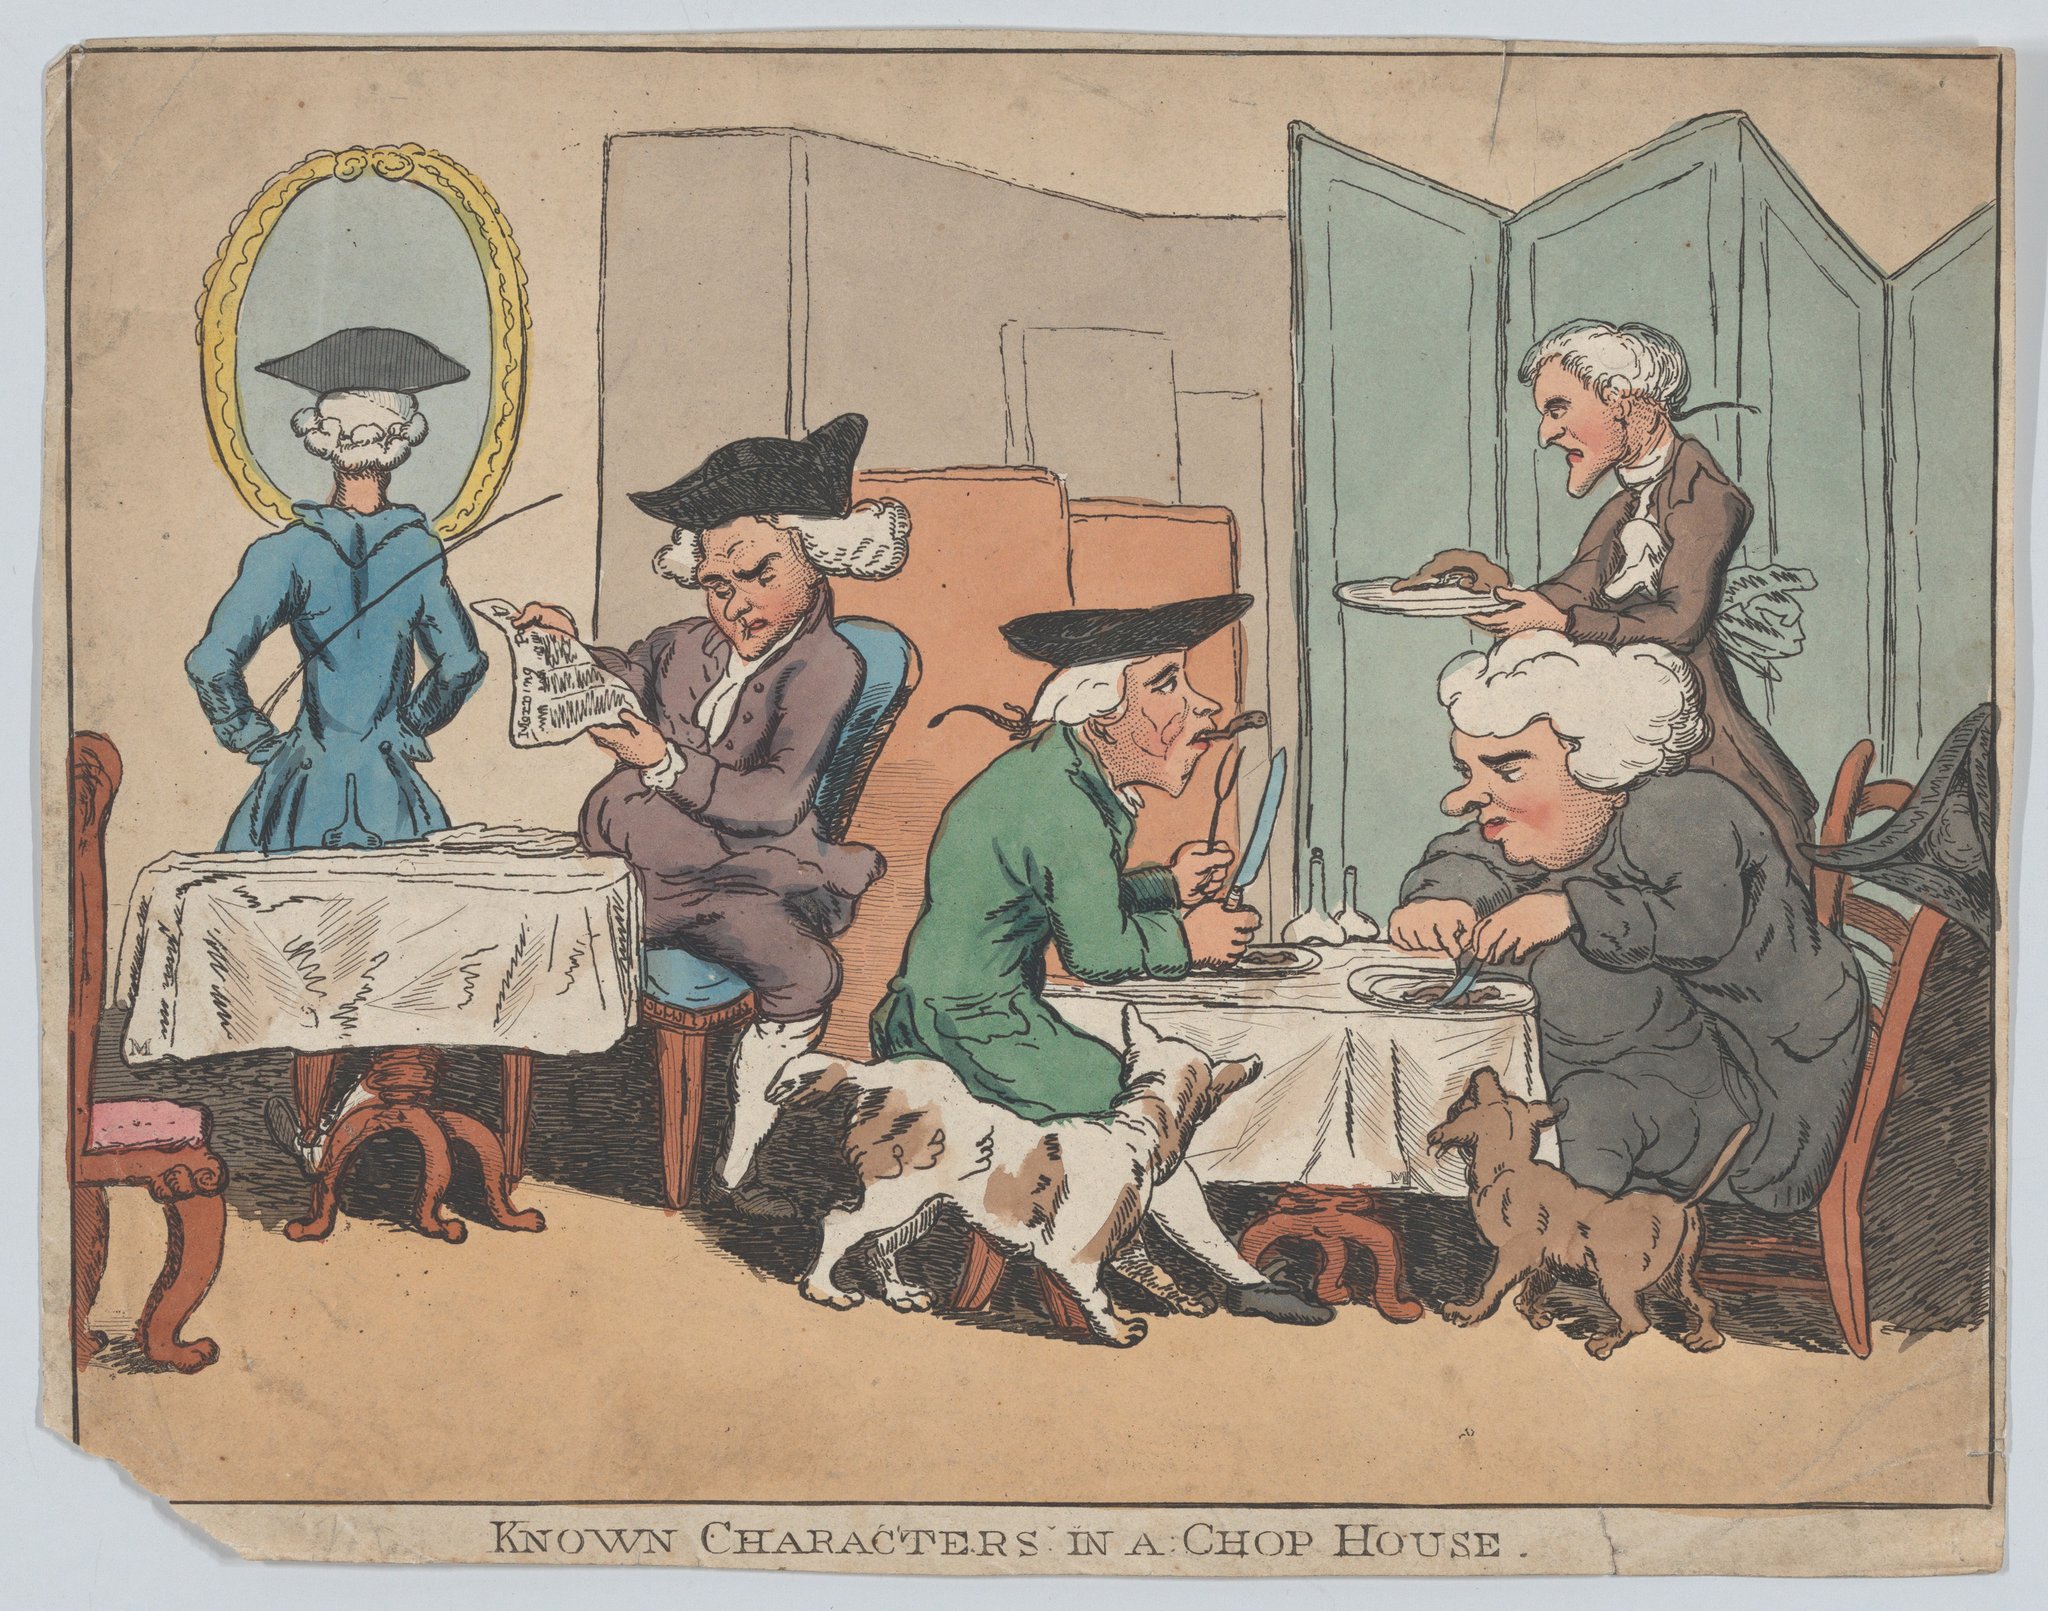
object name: print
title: Known Characters in a Chop House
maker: anonymous, british, 19th century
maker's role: artist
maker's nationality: british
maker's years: 1800-1900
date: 1800-1820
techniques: hand coloring, lithograph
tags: satire,men,dogs,dining